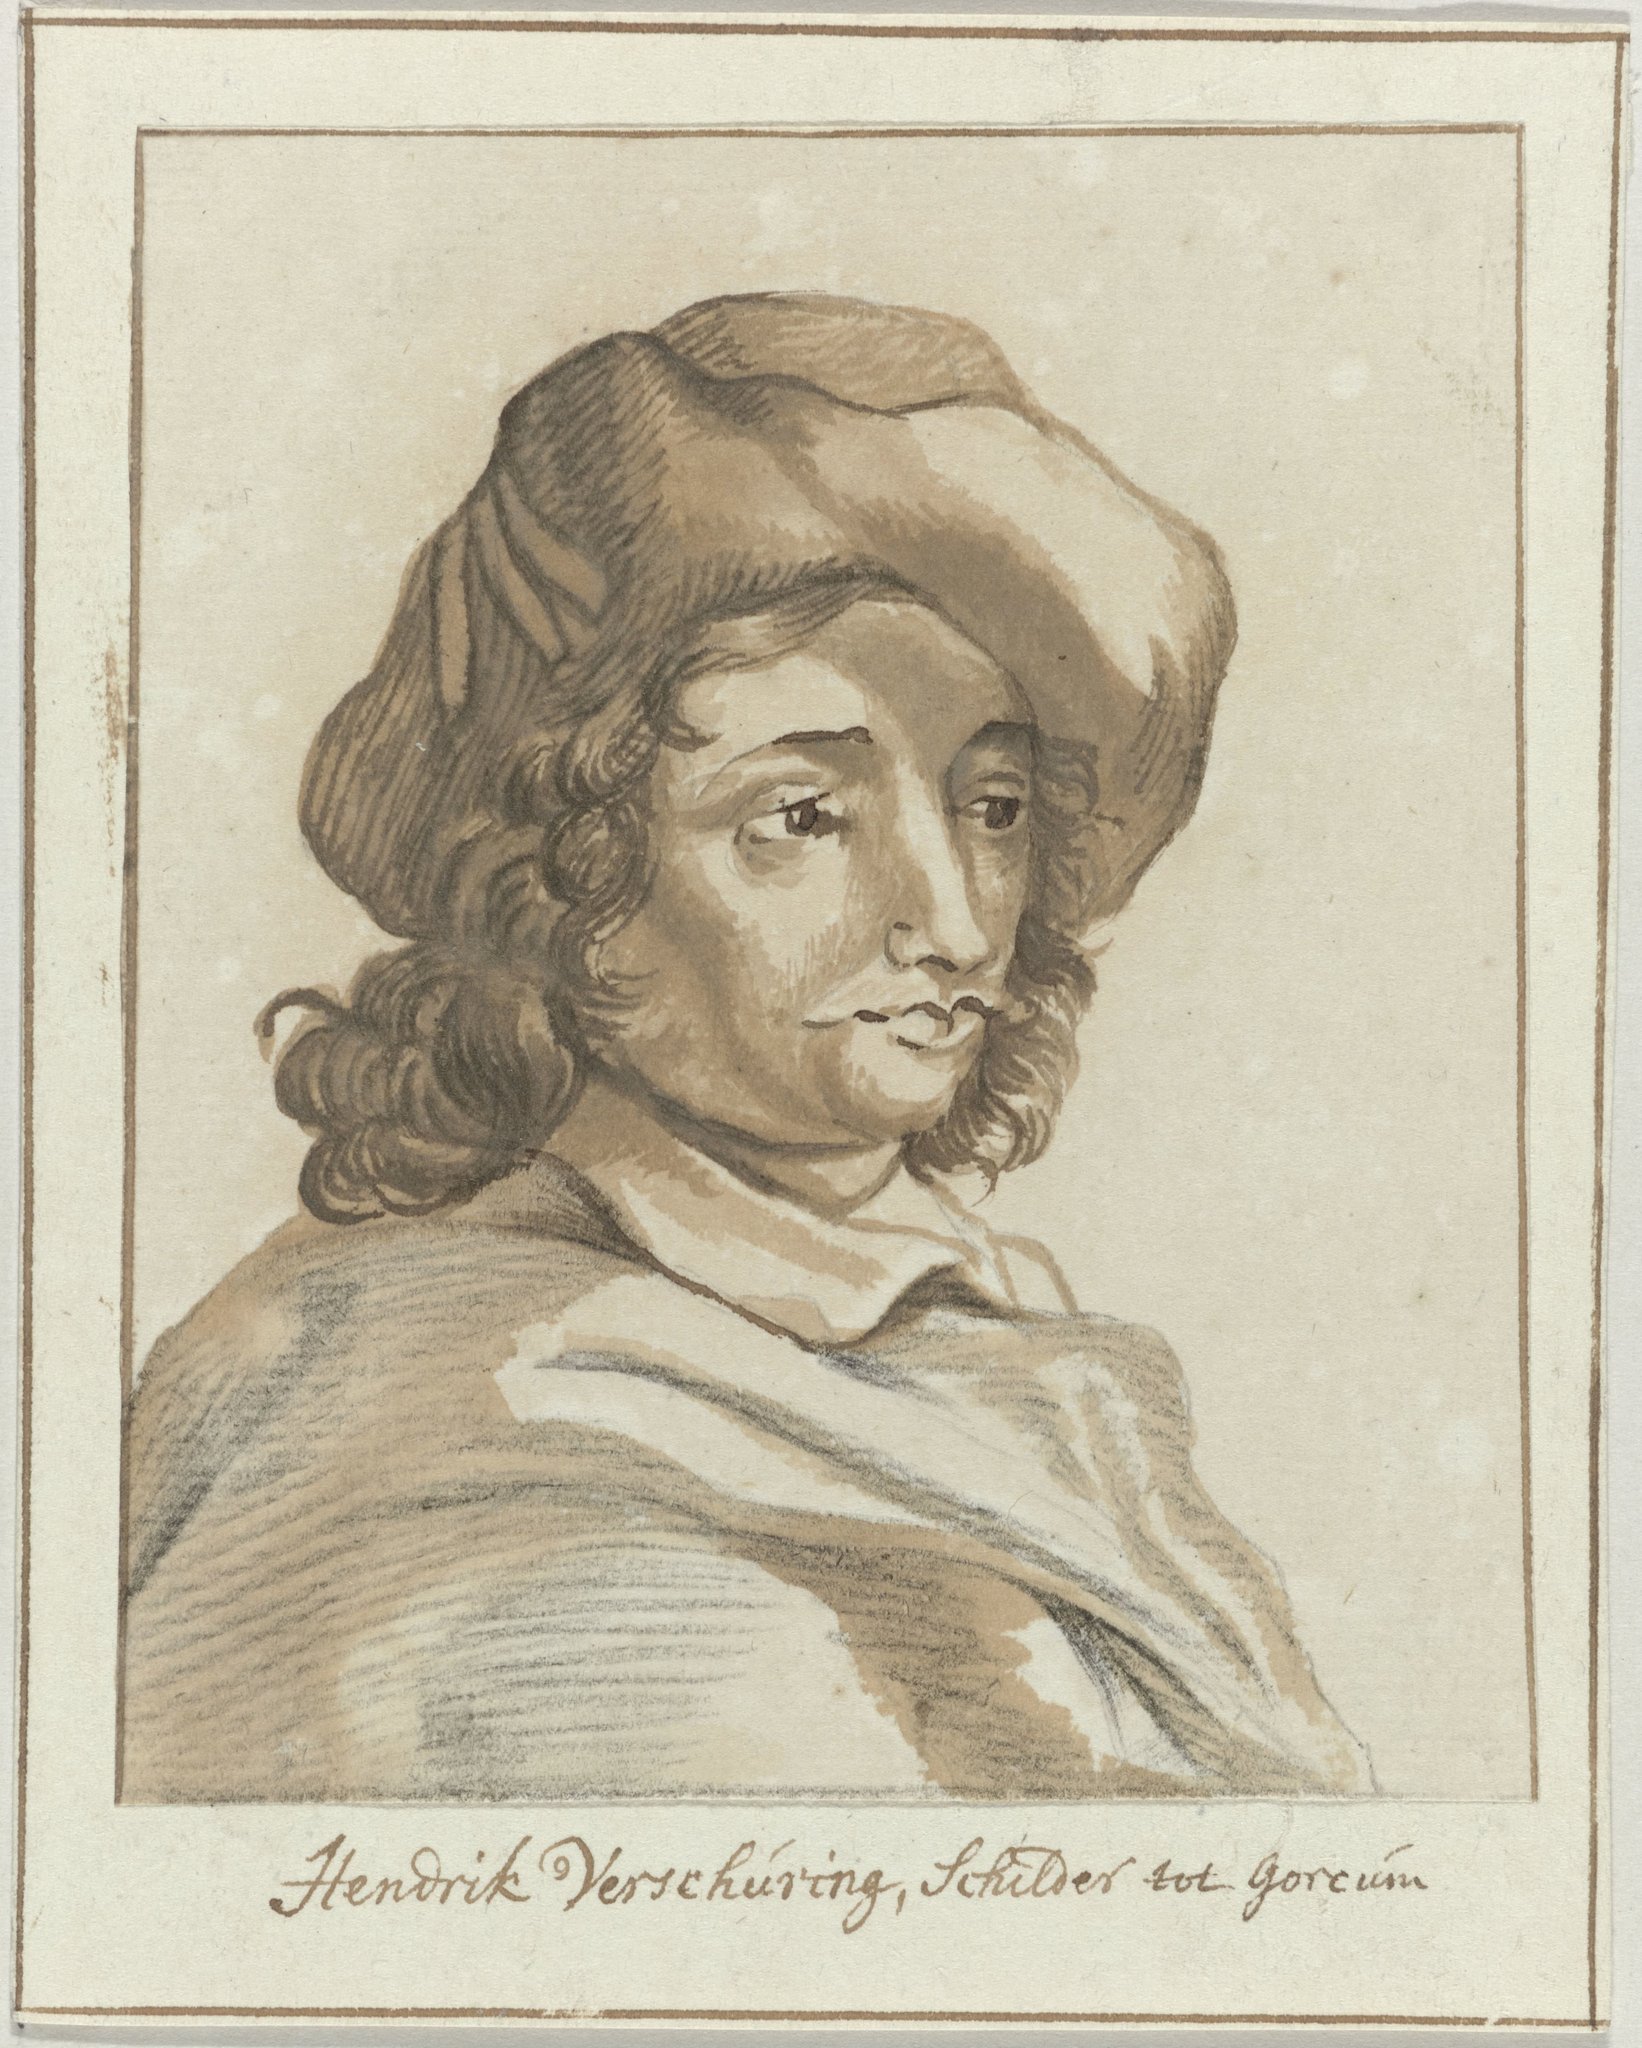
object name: drawing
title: Portret van de schilder Hendrik Verschuring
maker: Anonymous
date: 1645-1759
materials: chalk, paper, pencil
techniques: brush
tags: dordrecht, print maker, draughtsman, hendrik verschuring, historical persons, portrait, self-portrait of painter, portrait, self-portrait of artist